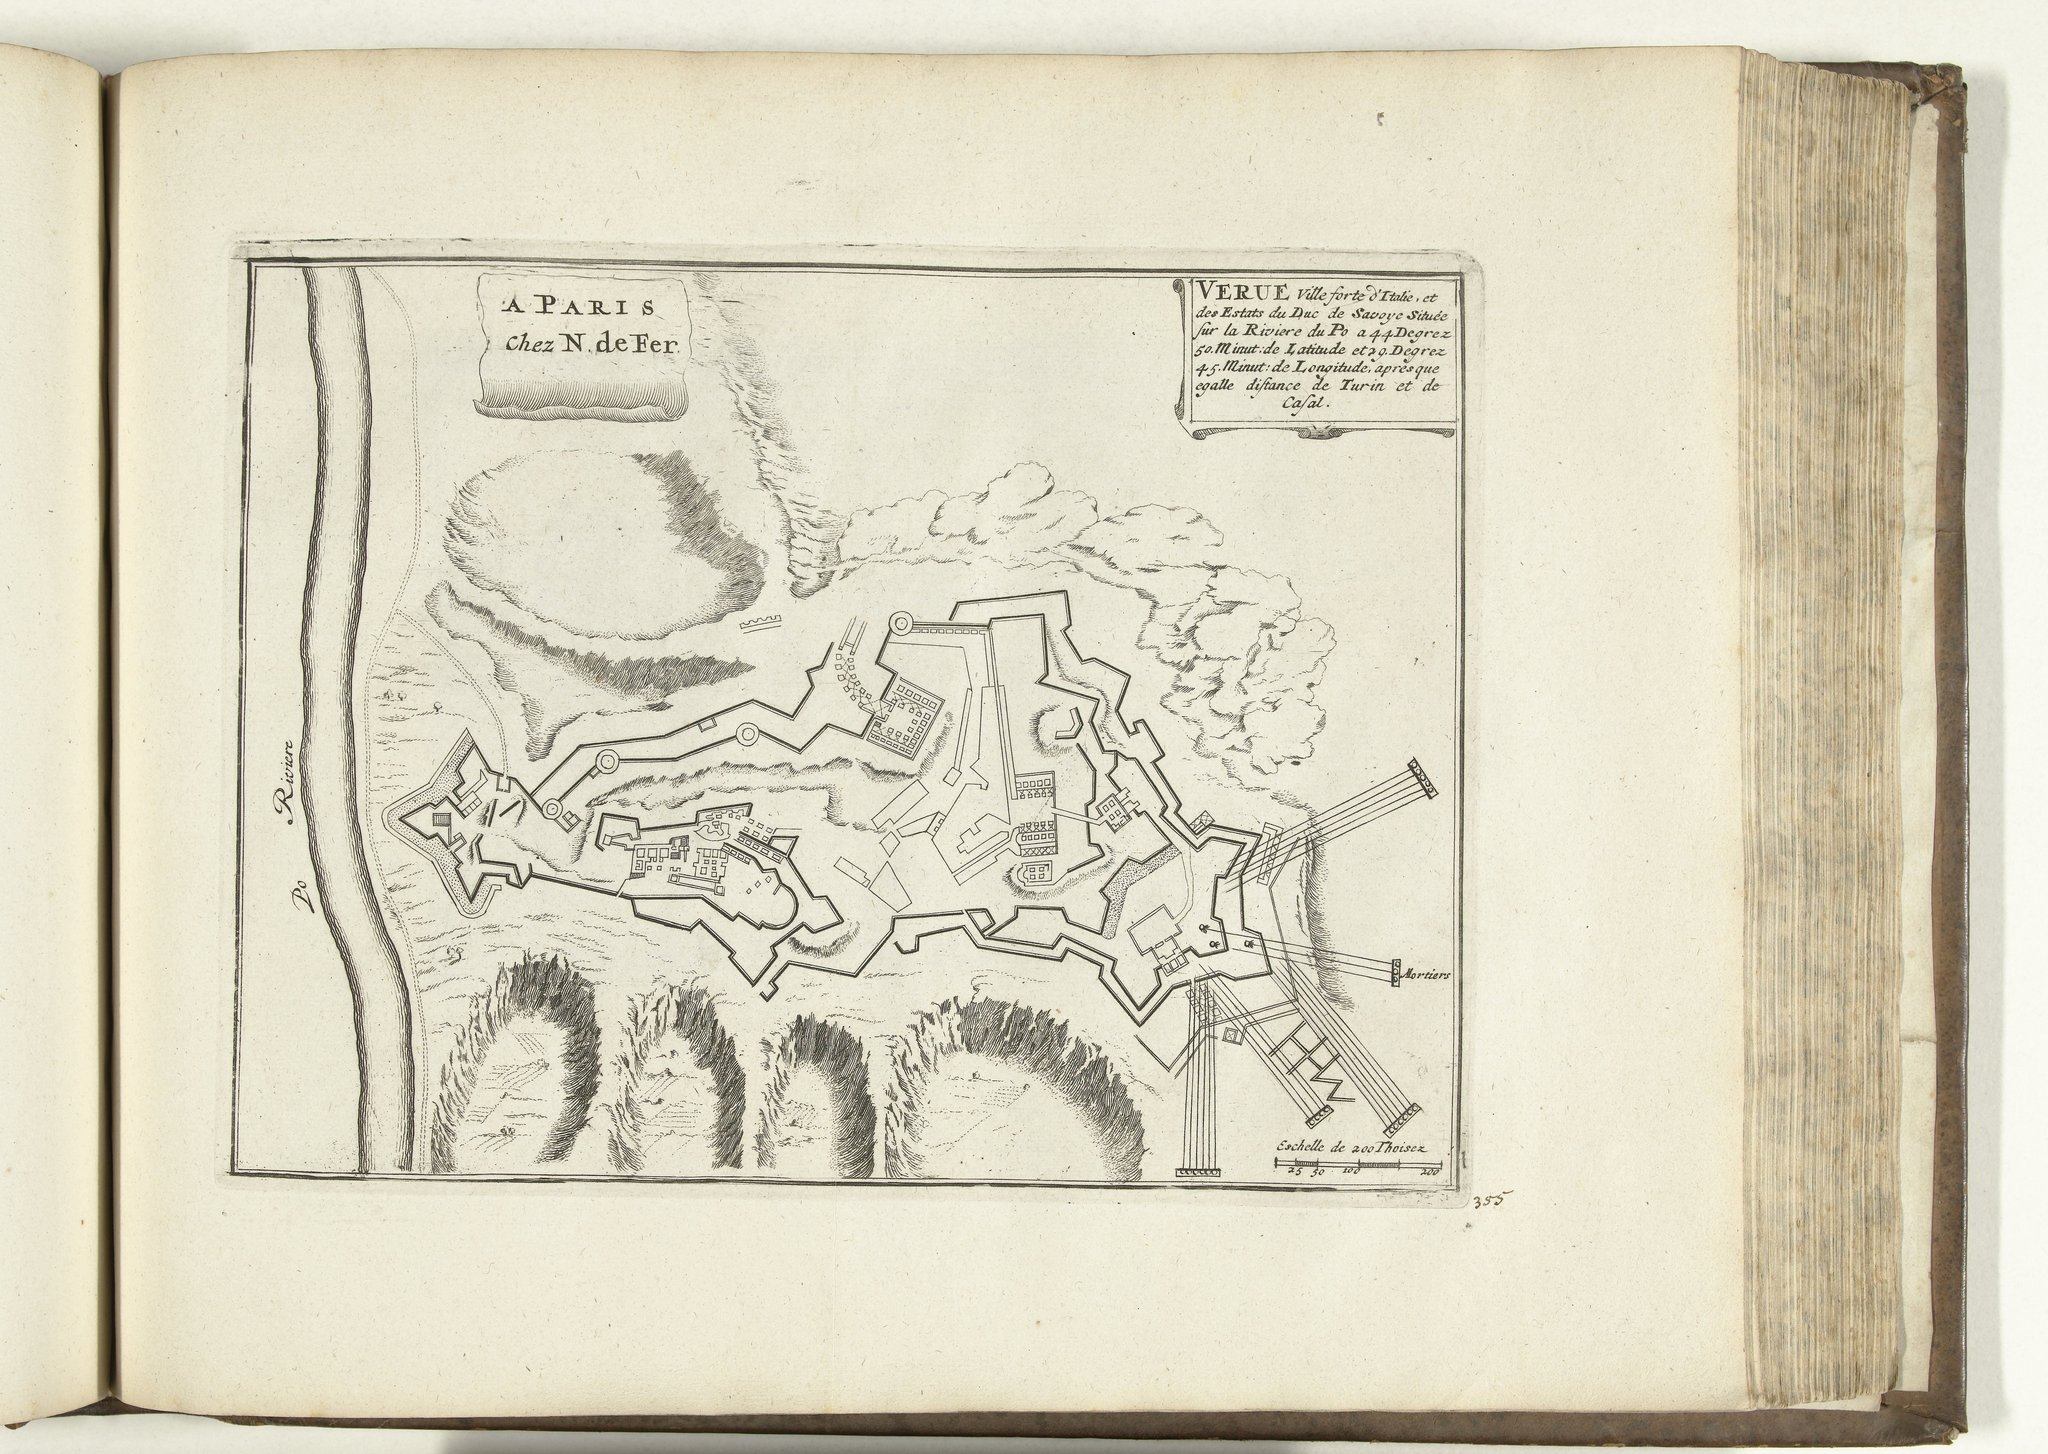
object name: print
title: Les Forces de l'Europe, Asie, Afrique et Amerique (...) Comme aussi les Cartes des Côtes de France et d'Espagne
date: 1726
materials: paper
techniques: etching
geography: leiden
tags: fortress, maps of cities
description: Plattegrond van de versterkingen rond de stad Verua (Verue) aan de Po in Piemonte. Plaat nr. 355 in deel XV van het prentwerk: Les Forces de l'Europe, Asie, Afrique et Amerique ... Comme aussi les Cartes des Côtes de France et d'Espagne uit 1726, dit tweede deel met 271 met de hand genummerde platen van vermaarde sterke steden en vestingen in het kader van de Spaanse Successieoorlog 1701-1713. Voor het merendeel zijn deze platen gekopieerd naar de anonieme Franse platen van vermaarde sterke steden en vestingen: in Les forces de l'Europe en in: Le theatre de la guerre, dans les Pays-Bas, beide oorspronkelijk uitgegeven door Nicolas de Fer te Parijs (1693-1697) in het kader van de Negenjarige Oorlog. Titel en opschriften in het Frans. Rechtsonder sporen van het weggepolijste nummer: 178.